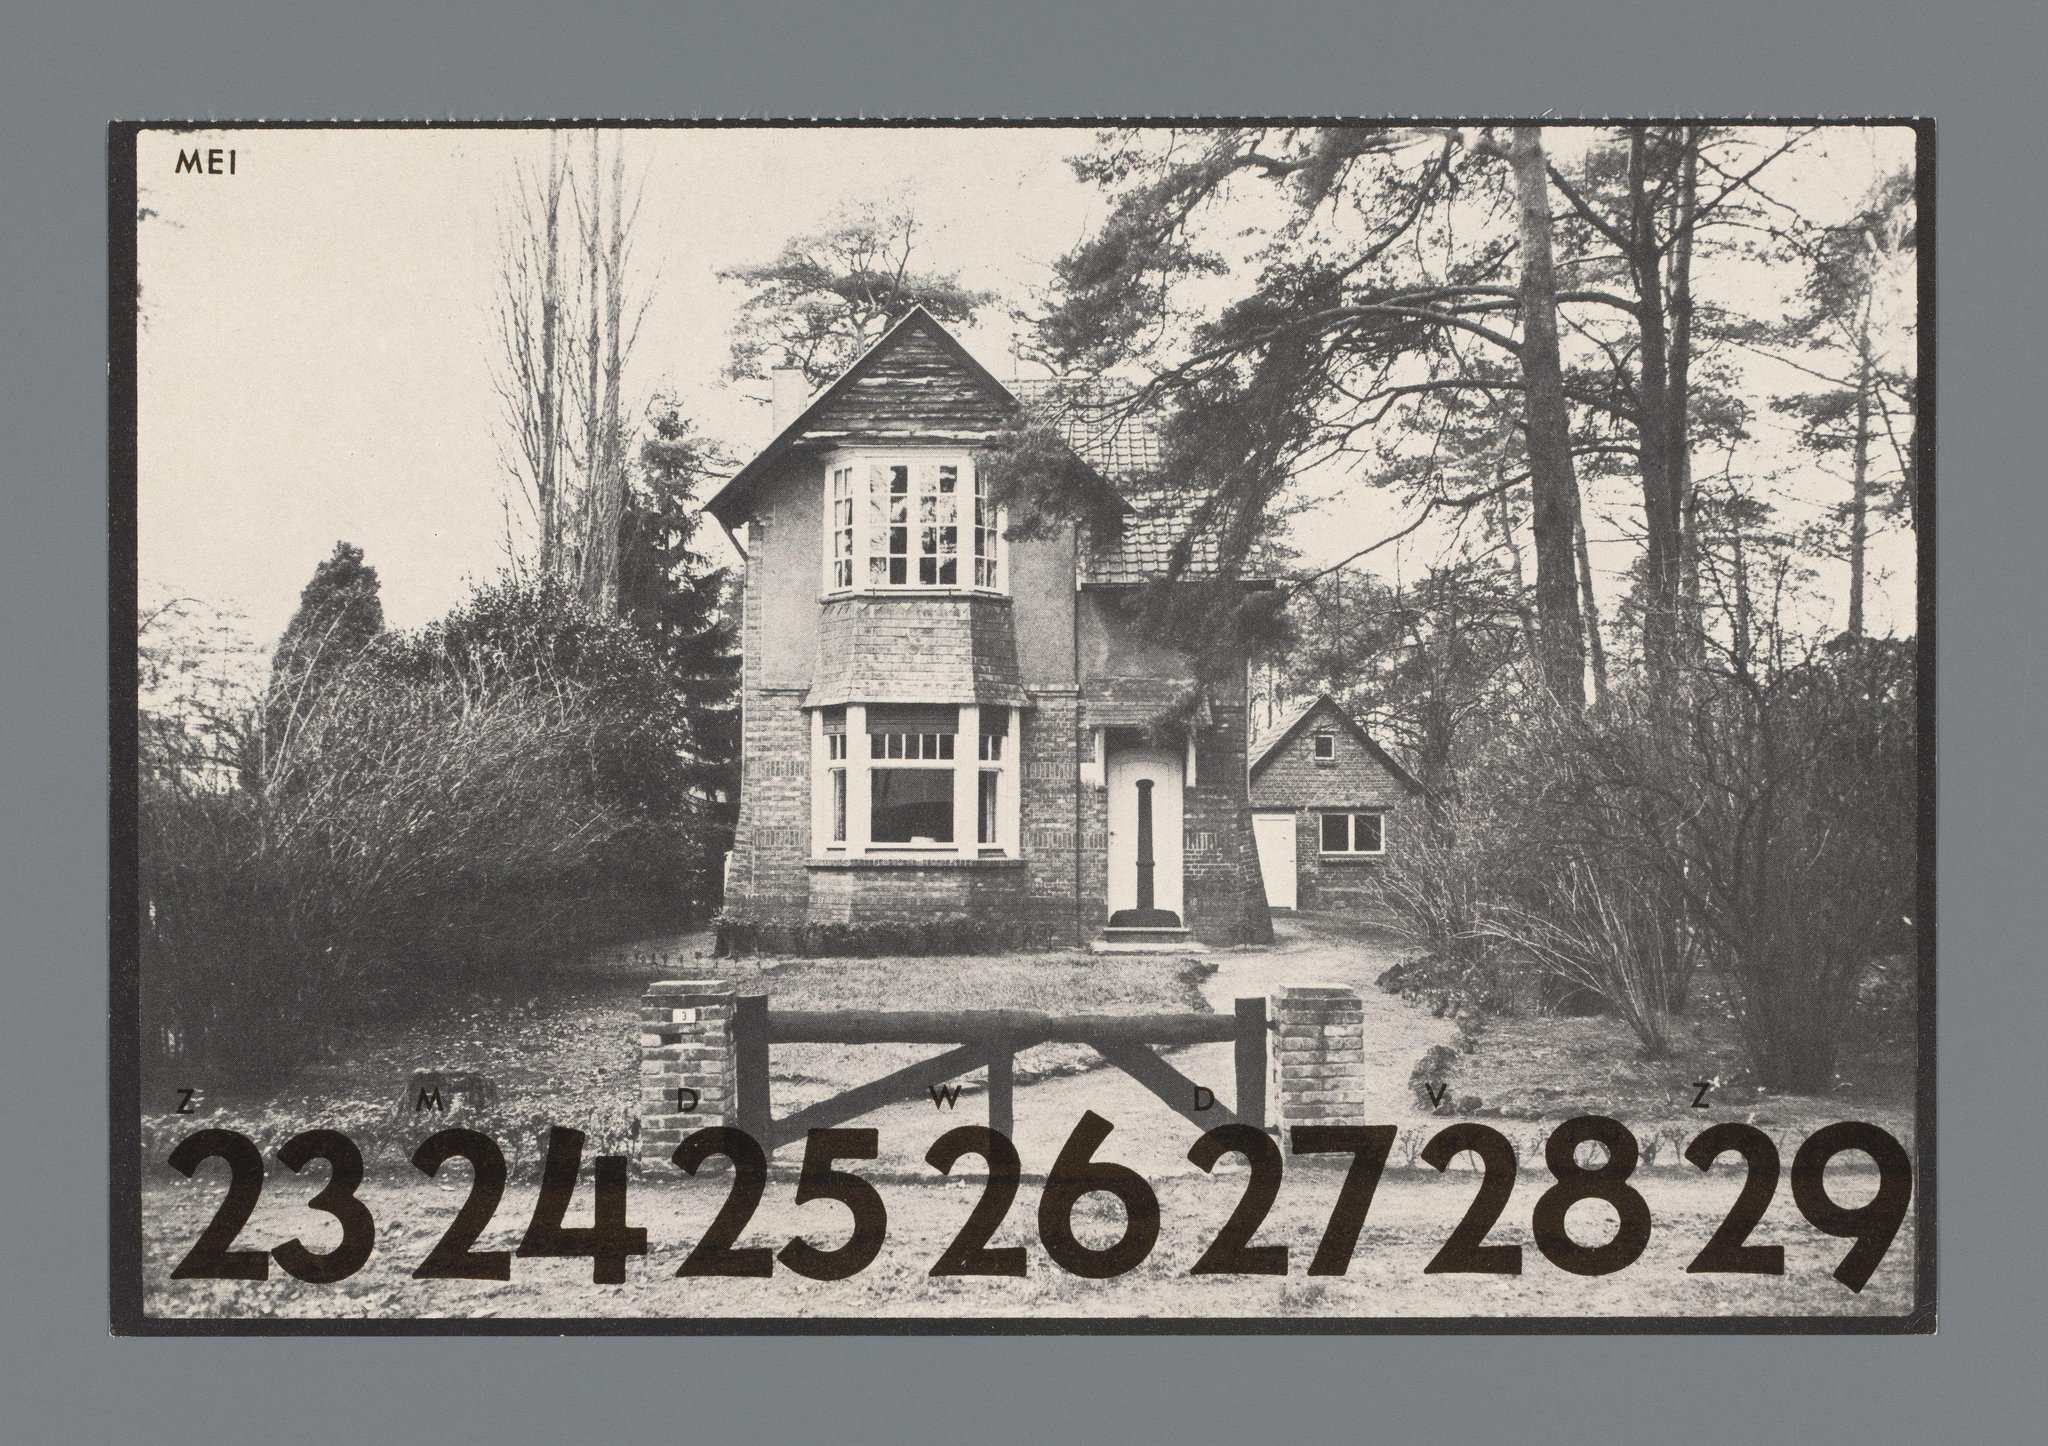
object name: photograph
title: België. Huizen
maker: Anonymous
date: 1900-1950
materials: paper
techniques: offset printed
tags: belgium